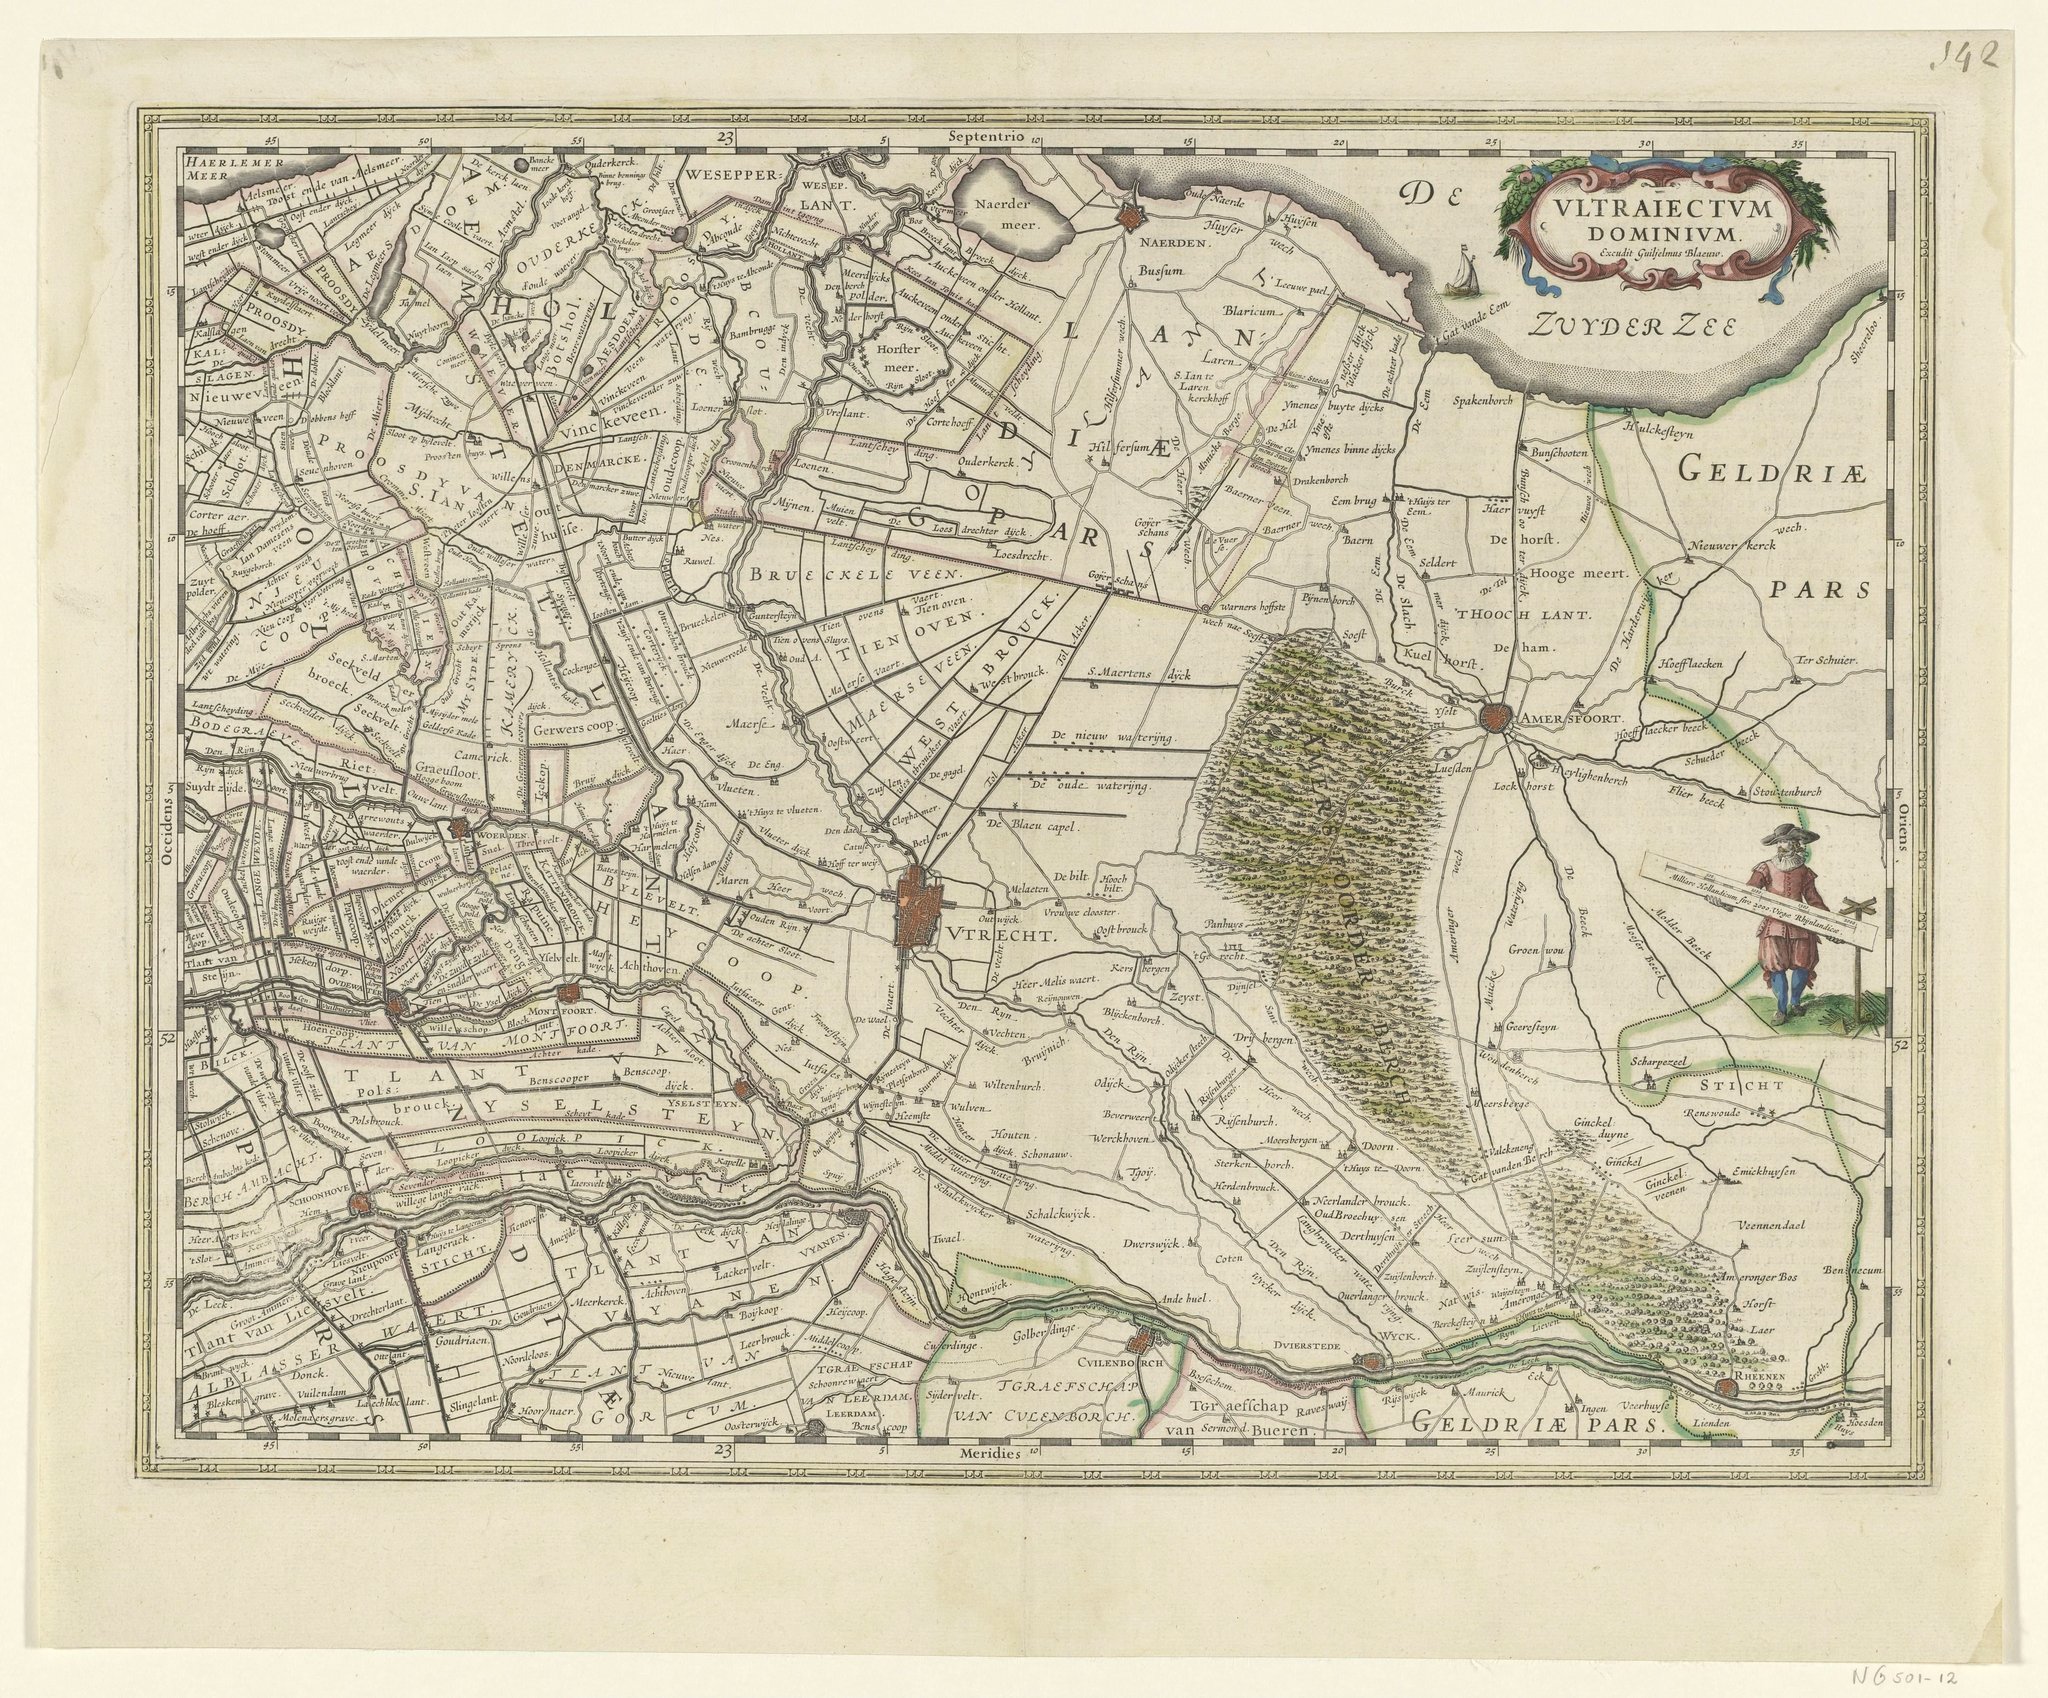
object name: map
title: Vltraiectvm Dominivm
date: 1630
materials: paper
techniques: engraving, etching, hand coloring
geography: amsterdam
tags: maps of separate countries or regions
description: Kaart van de provincie Utrecht op een schaal van 1:150.000 met het noorden rechts. Rechtsboven een cartouche met de titel. Rechtsmidden een staande landmeter met een afstandsbalk in de hand die een schaal in Hollandse mijlen aangeeft.